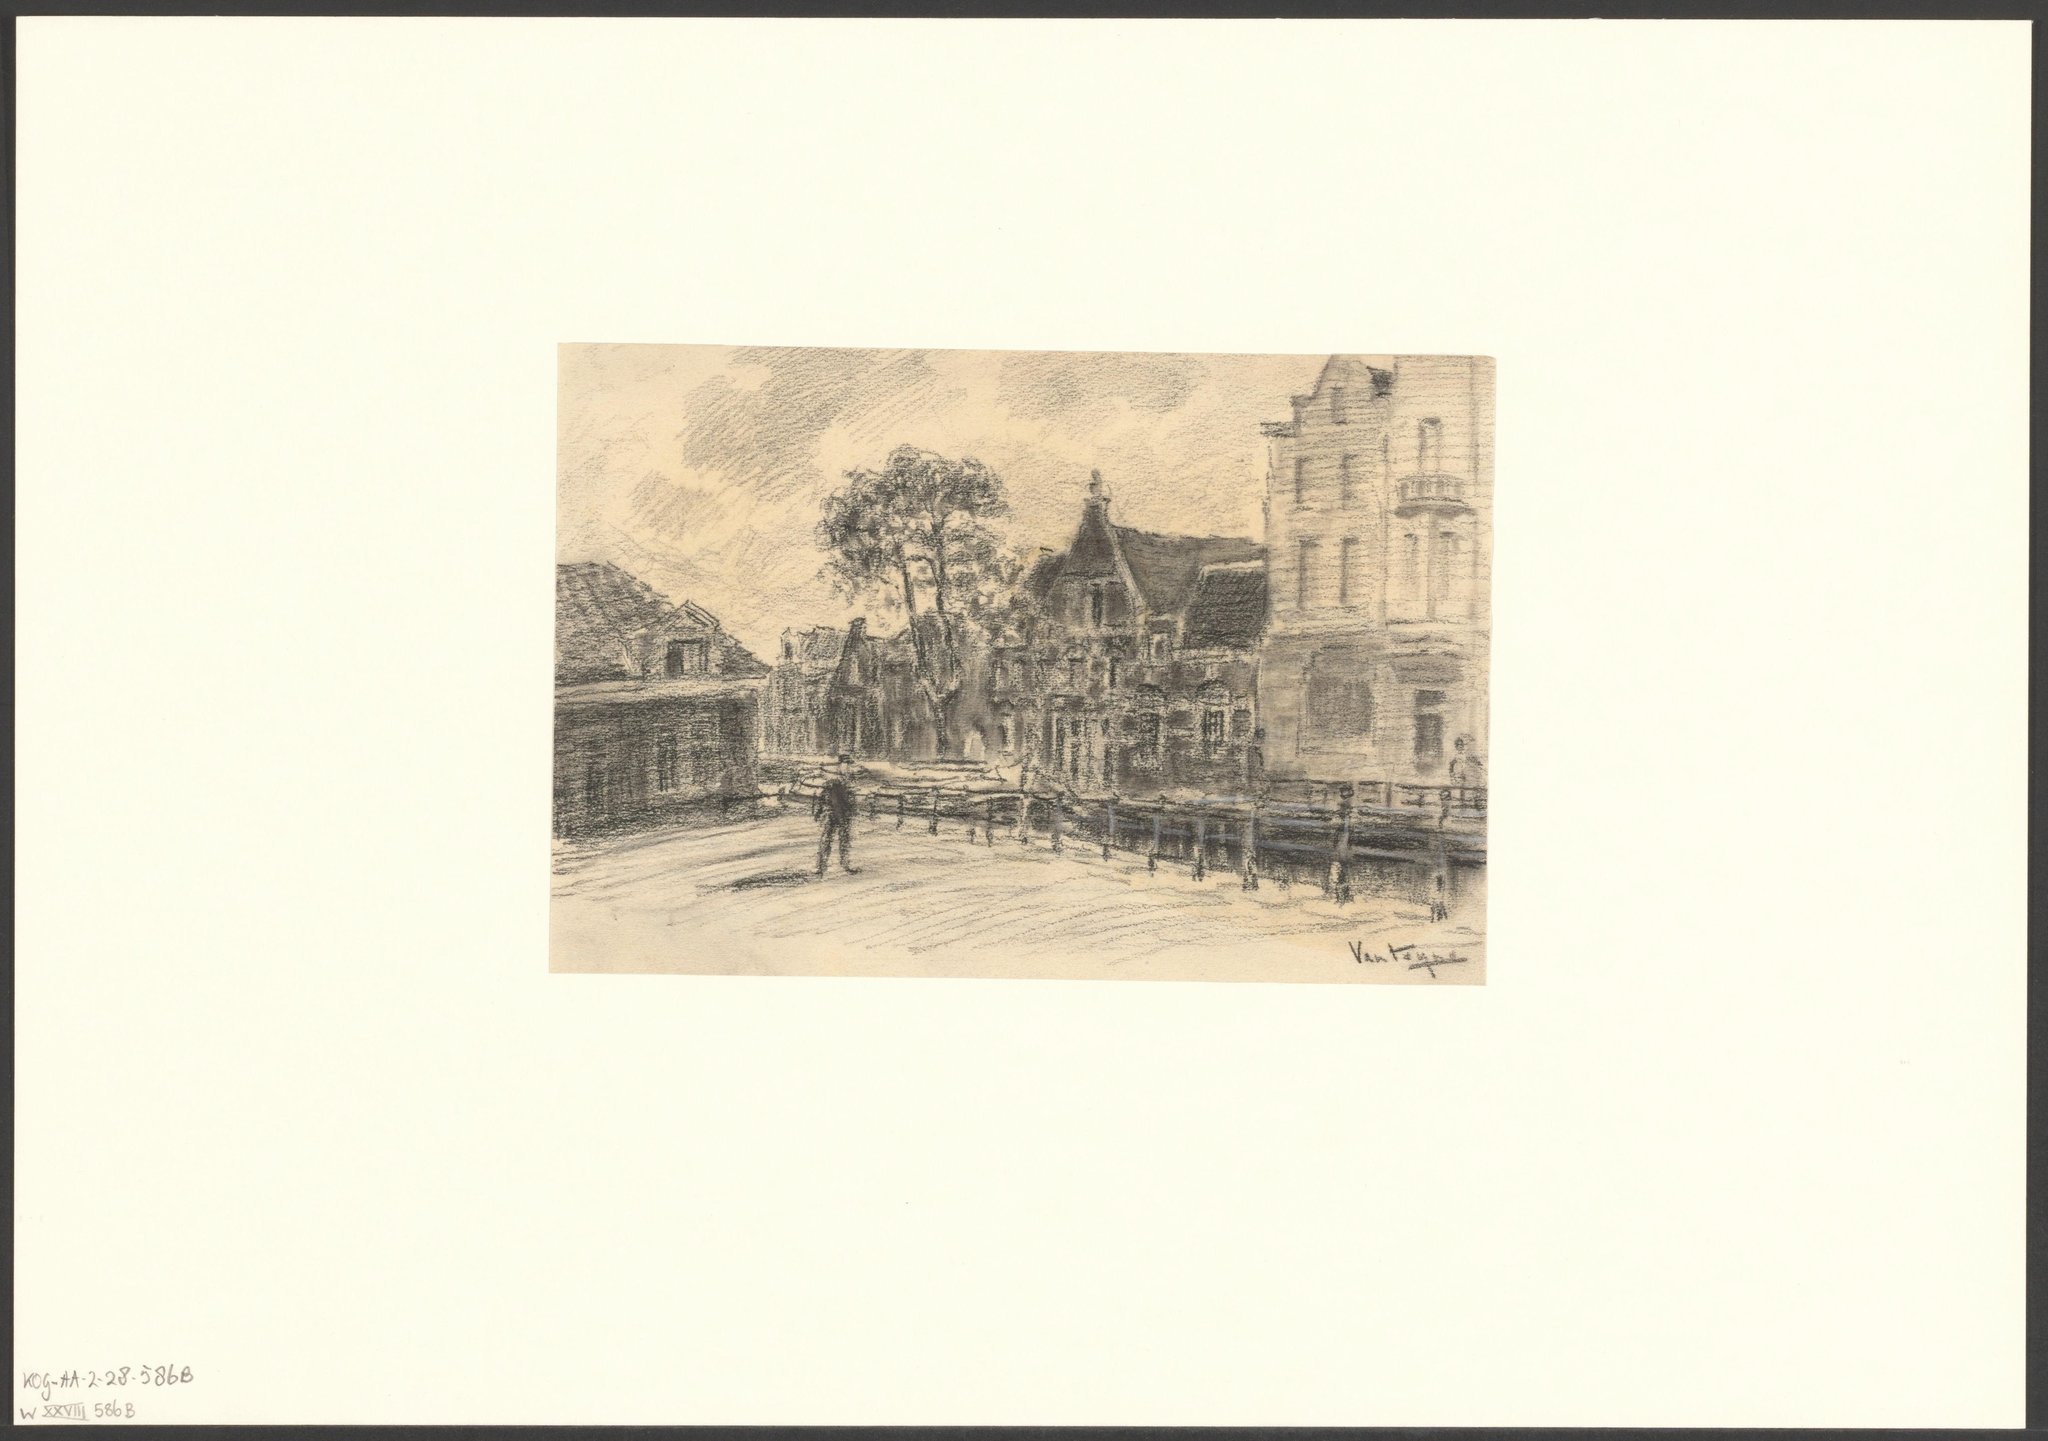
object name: drawing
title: Gezicht op de Overtoom en het Aalsmeerderveerhuis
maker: anthonie van teijn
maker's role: draughtsman, painter, print maker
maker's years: 1863-1943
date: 1910-1927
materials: chalk, paper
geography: amsterdam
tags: city-view in general; 'veduta', façade (of house or building), street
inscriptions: signature: ‘Van Teyne’, date: ‘Oct 1927’, inscription: ‘Nabij de Overtoom (...) van Eck’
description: Tekening binnen de Atlas Van Eck ingedeeld op wijknummer 28.